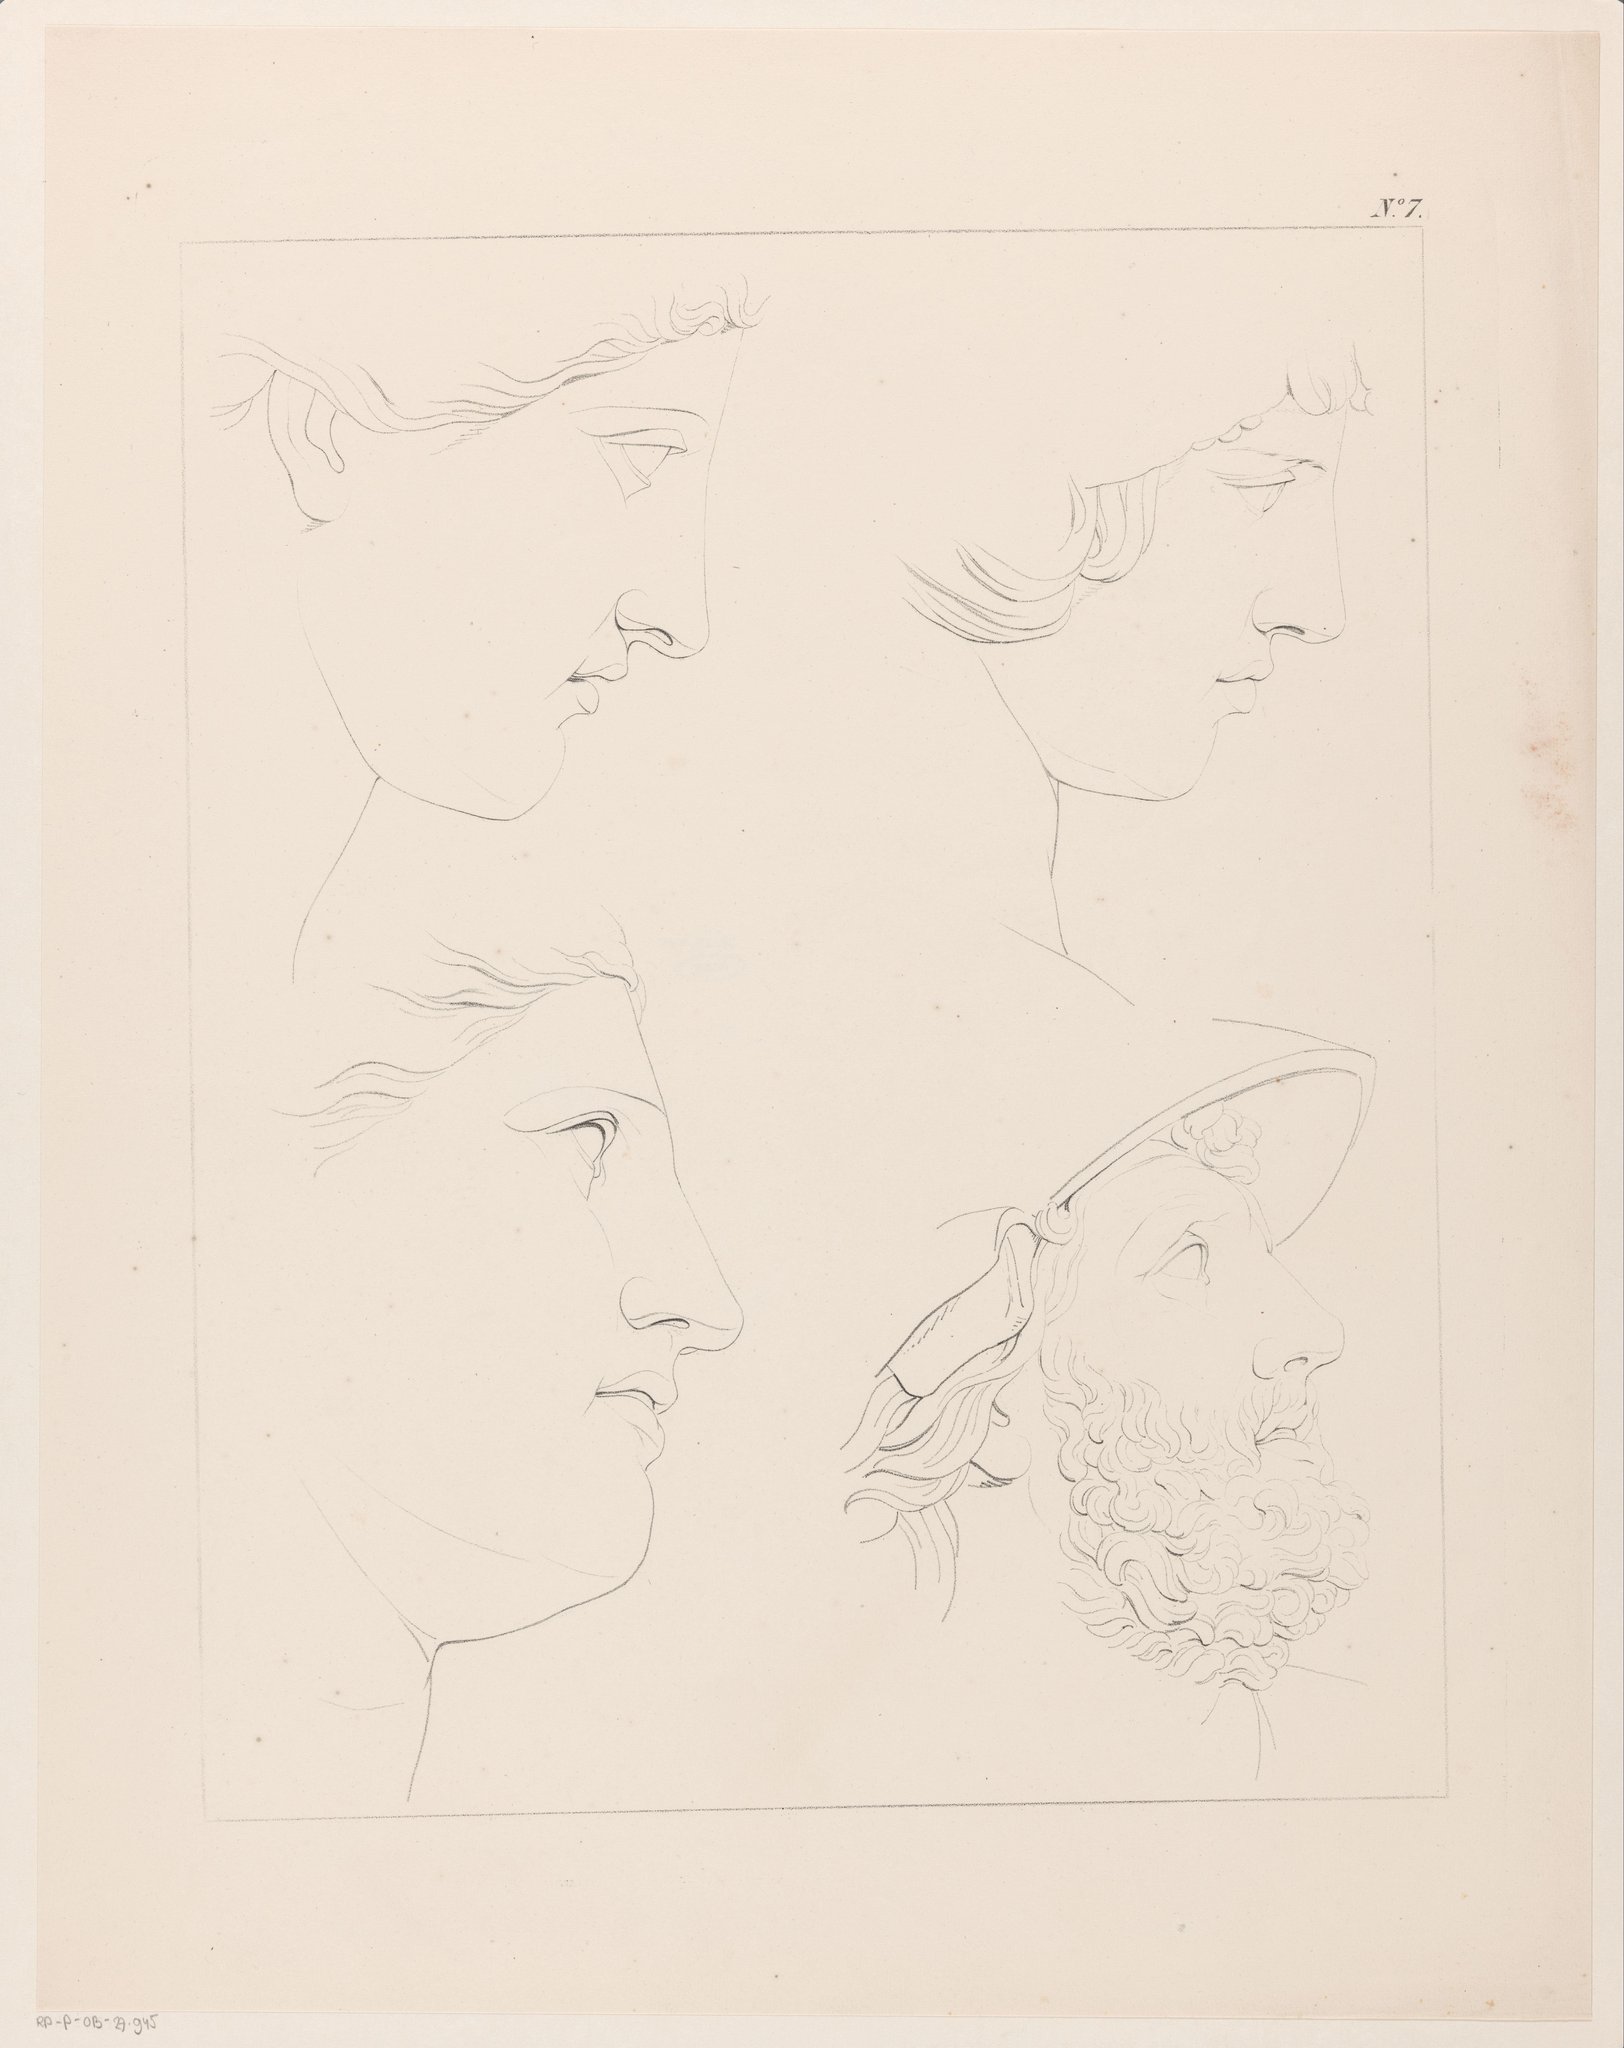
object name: print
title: Vier gezichten van opzij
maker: jean augustin daiwaille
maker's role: draughtsman, print maker, printer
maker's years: 1786-1850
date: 1820-1833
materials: paper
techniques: lithograph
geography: amsterdam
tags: face (+ sideview, profile)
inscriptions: collector's mark: Lugt 2228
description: De gezichten zijn afkomstig van klassieke sculpturen. De figuur rechtsonder draagt een baard en een helm. Genummerd rechtsboven: No. 7.